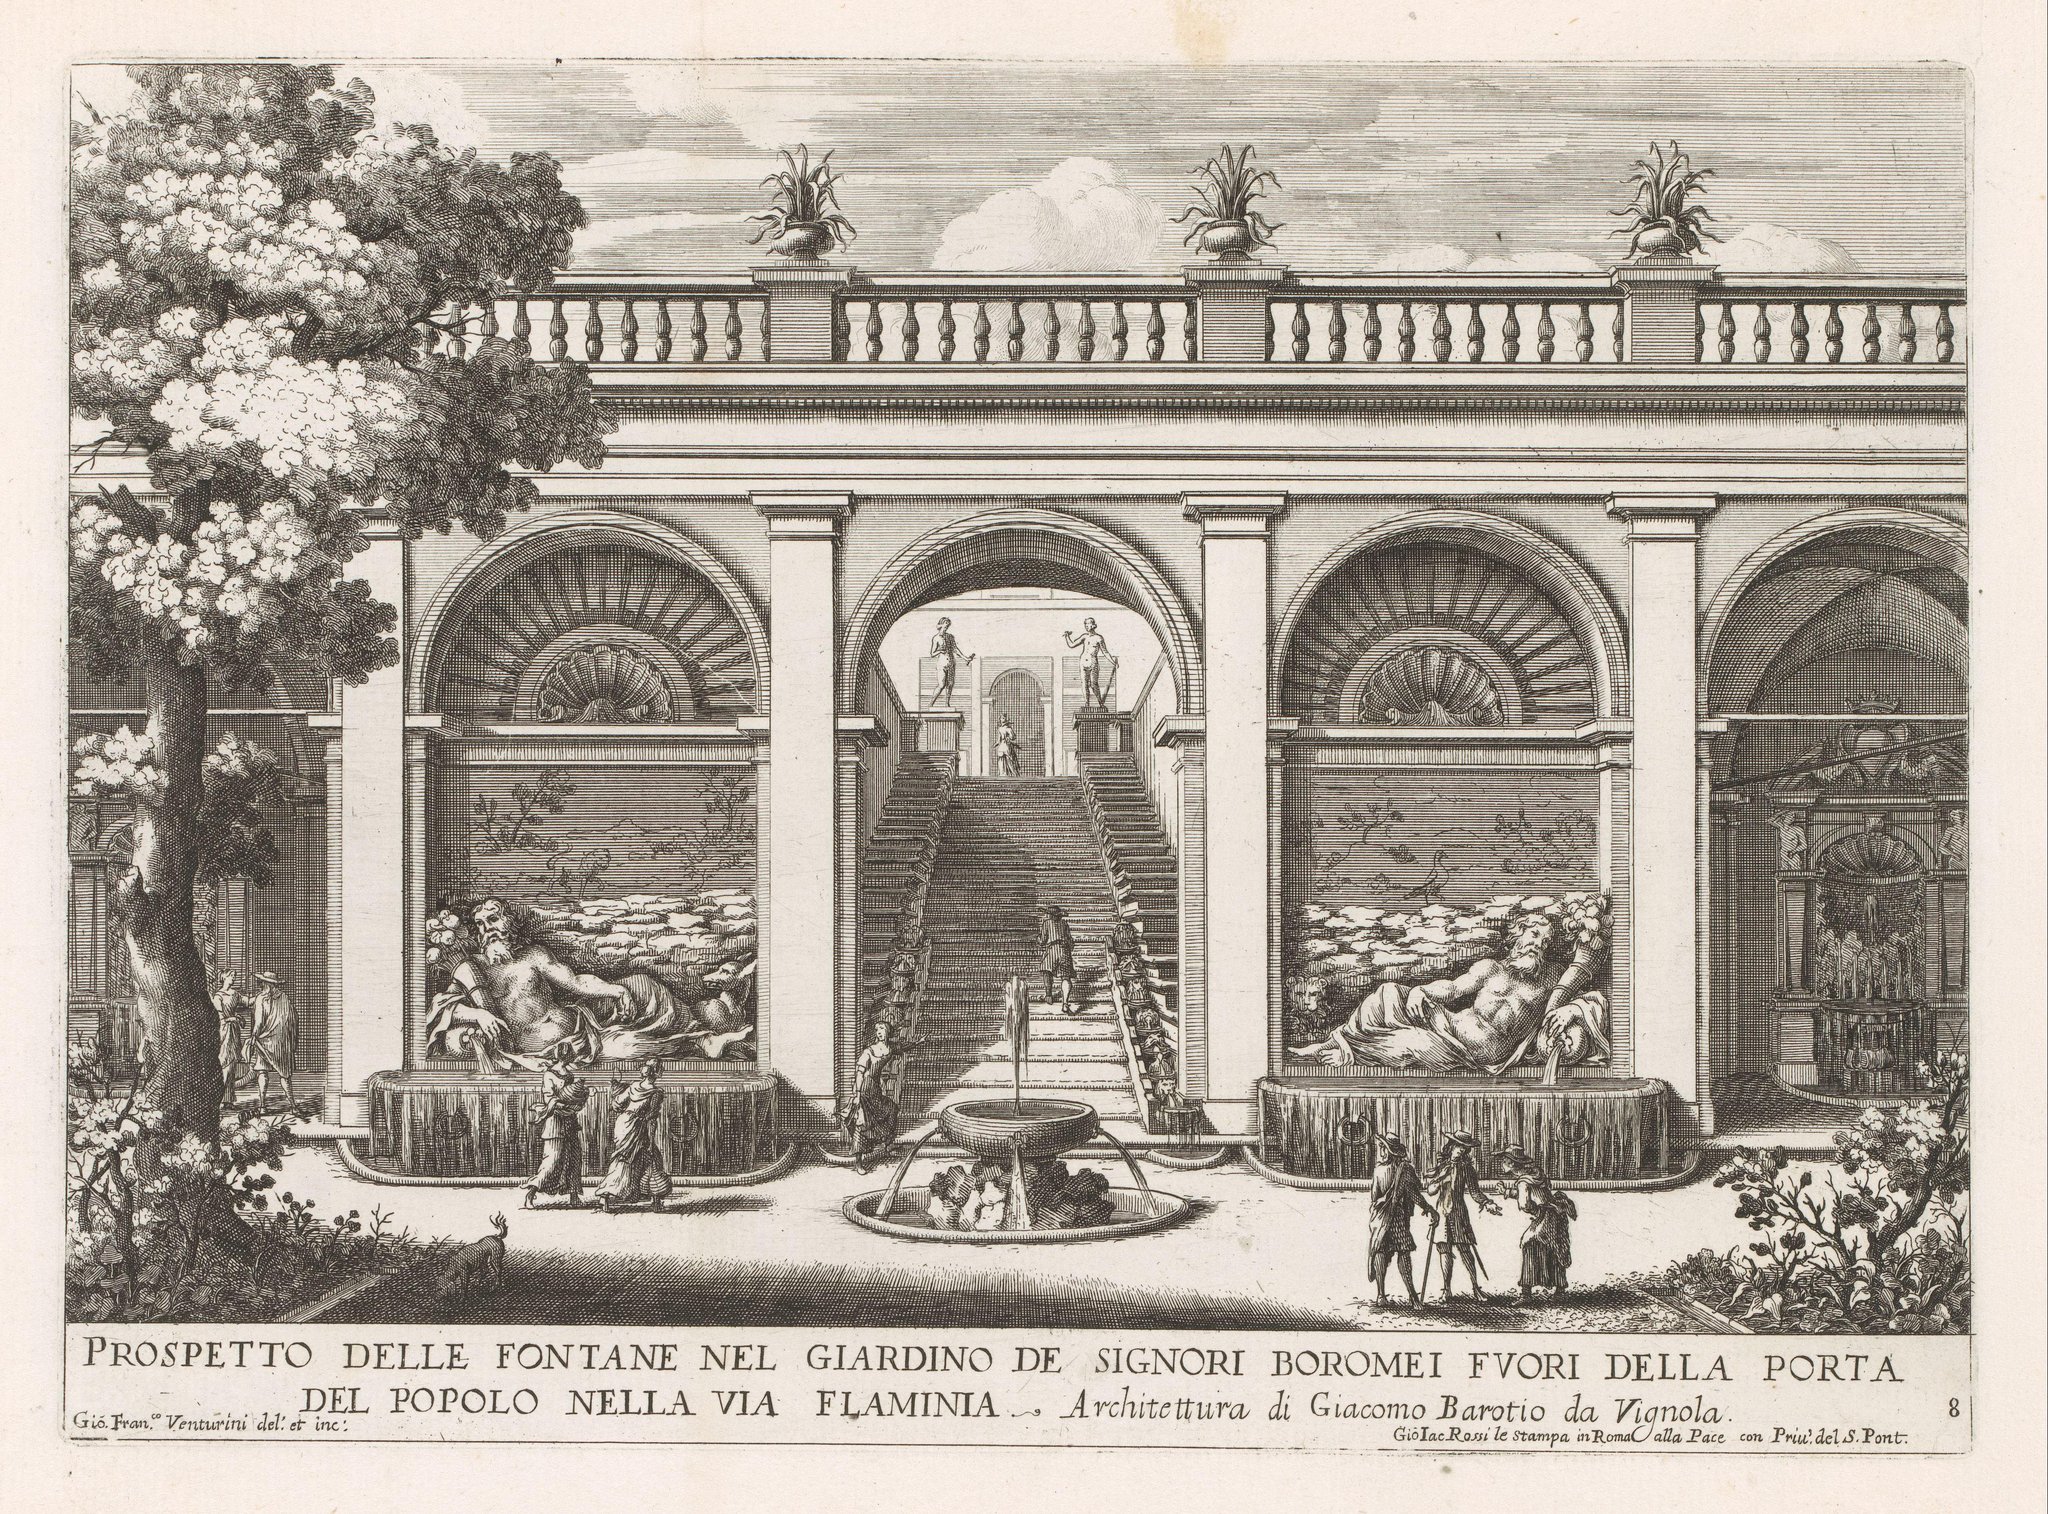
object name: print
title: Prospetto delle fontane nel giardino de signori Boromei (...)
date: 1653-1691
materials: paper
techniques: etching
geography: italy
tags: ornamental fountain, rome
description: Tuin met een trap en twee fonteinen met liggende riviergoden. Volgens het onderschrift de tuinen van een paleis van de familie Borromeo. Mogelijk gaat het om Palazzo Borromeo aan de Via Flaminia. Genummerd rechtsonder: 8. De prent maakt deel uit van een album.